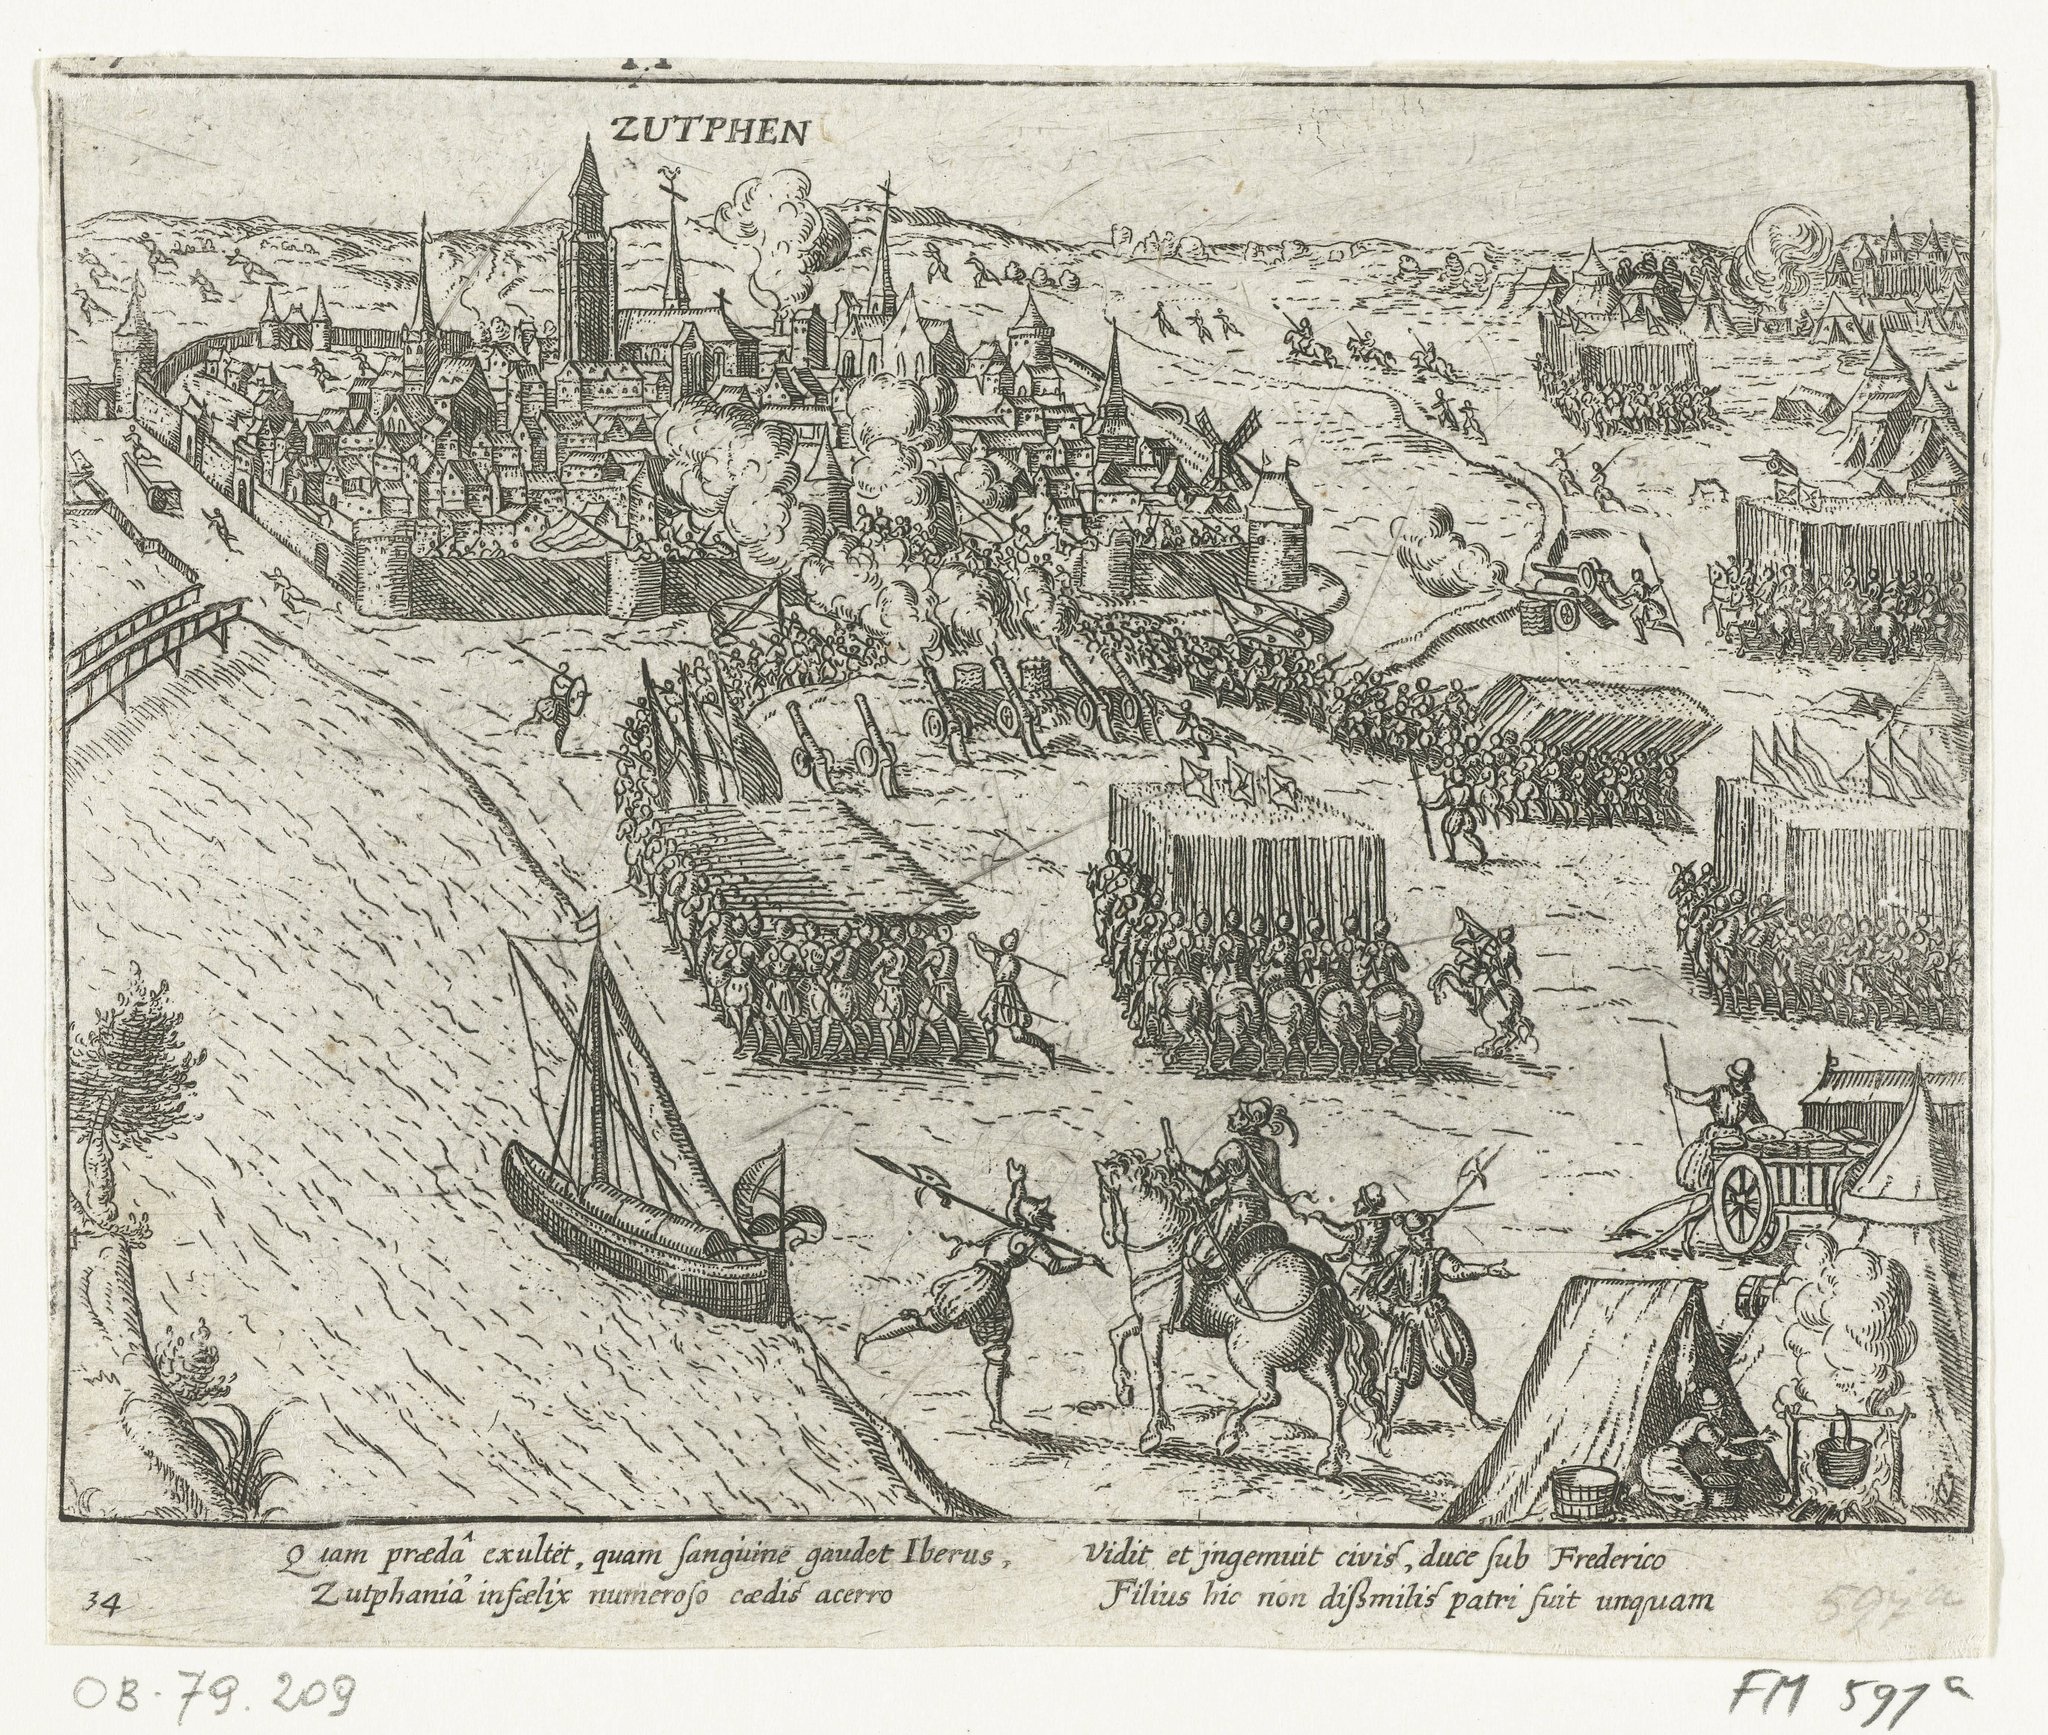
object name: print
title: Zutphen ingenomen door Don Frederik, 1572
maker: Anonymous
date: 1613-1615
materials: paper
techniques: etching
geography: northern netherlands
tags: siege, position war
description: Beschieting en bestorming van Zutphen door de Spaanse troepen onder Don Frederik, 16 november 1572. Gezicht vanuit het legerkamp, op de voorgrond Don Frederik te paard, in de verte de belegerde stad. Met onderschrift van 4 regels in het Latijn. Genummerd: 34. Bedrukt op achterzijde met tekst in het Latijn.